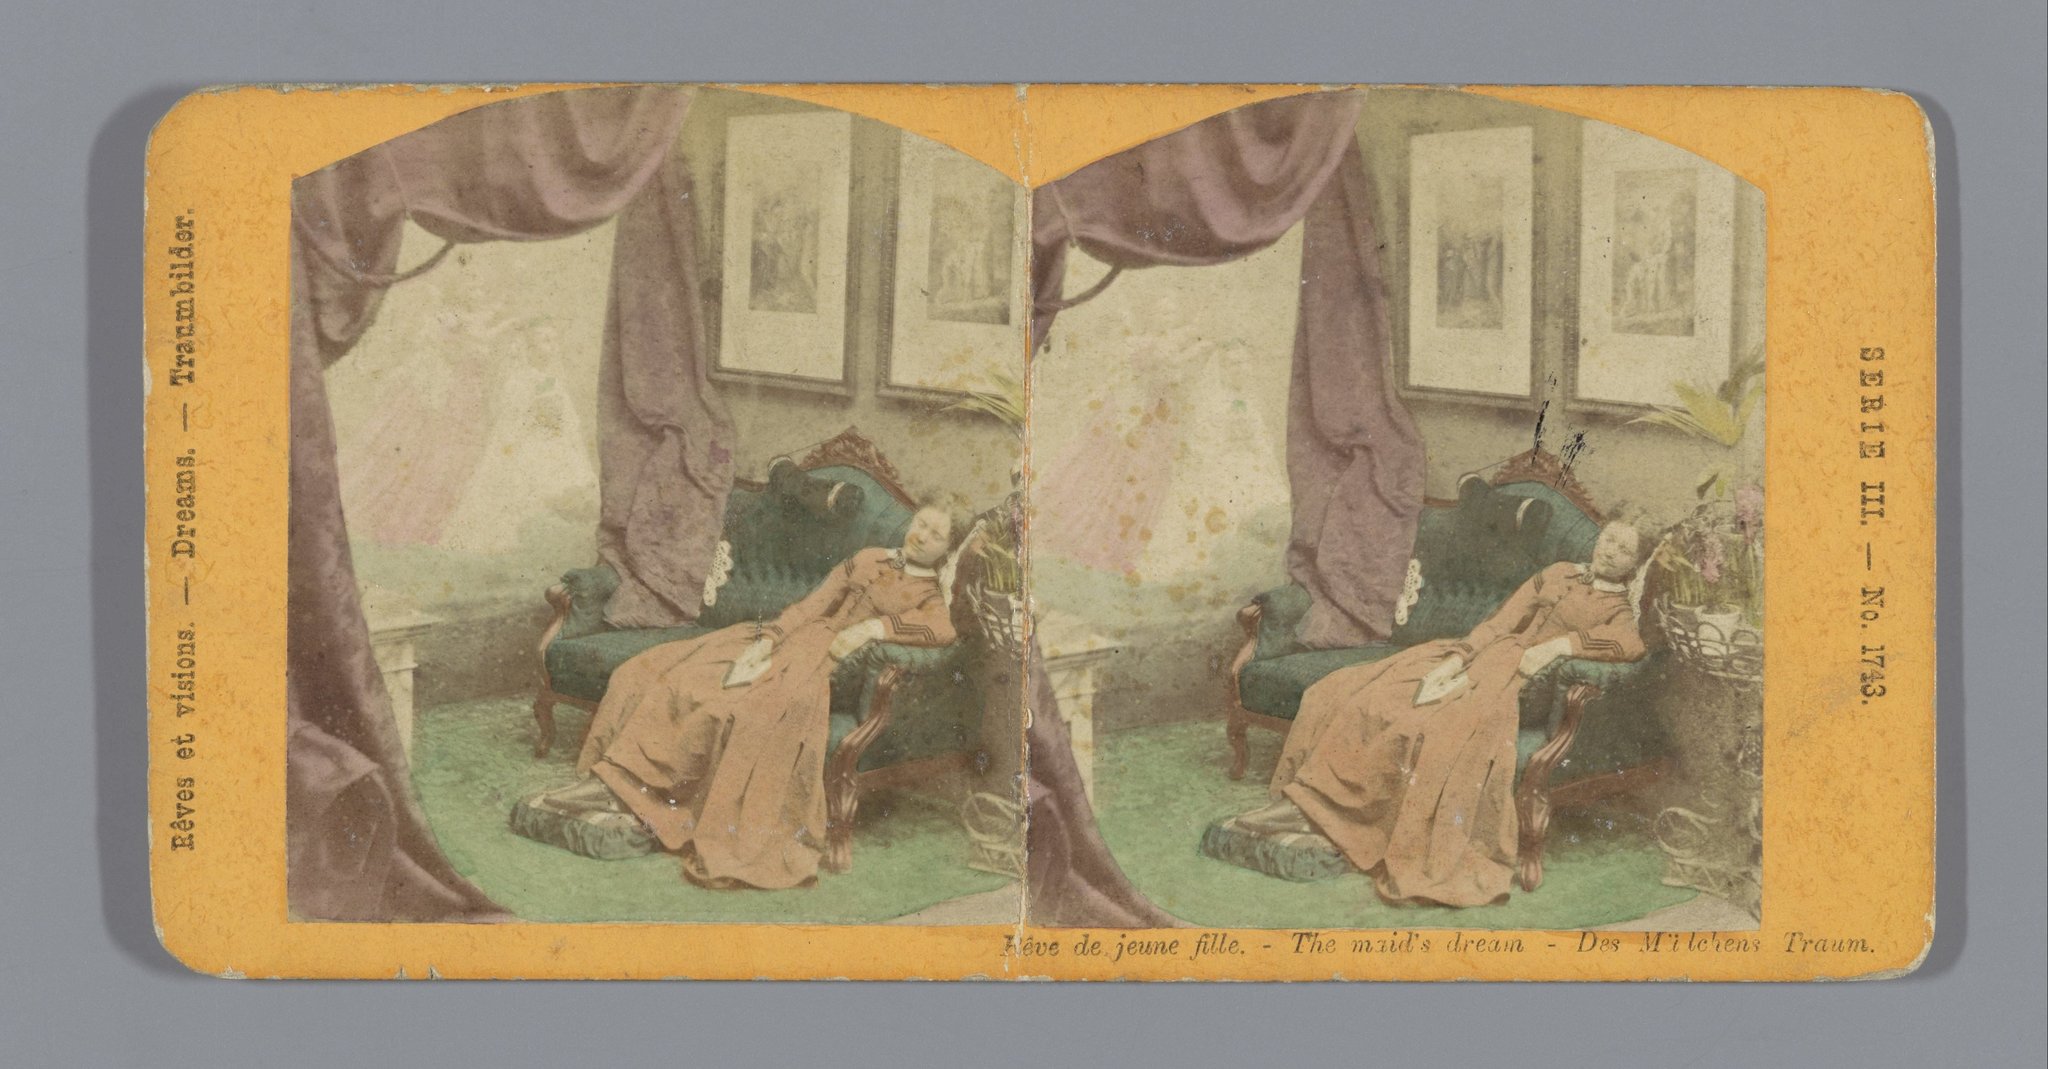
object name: stereograph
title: Rêve de jeune fille / The maid's dream / Des Mädchens Traum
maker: Anonymous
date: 1868-1890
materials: cardboard, paper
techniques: albumen print, hand coloring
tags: adolescent, young woman, maiden, dream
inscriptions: inscription: ‘Serie III. - No. 1743.’